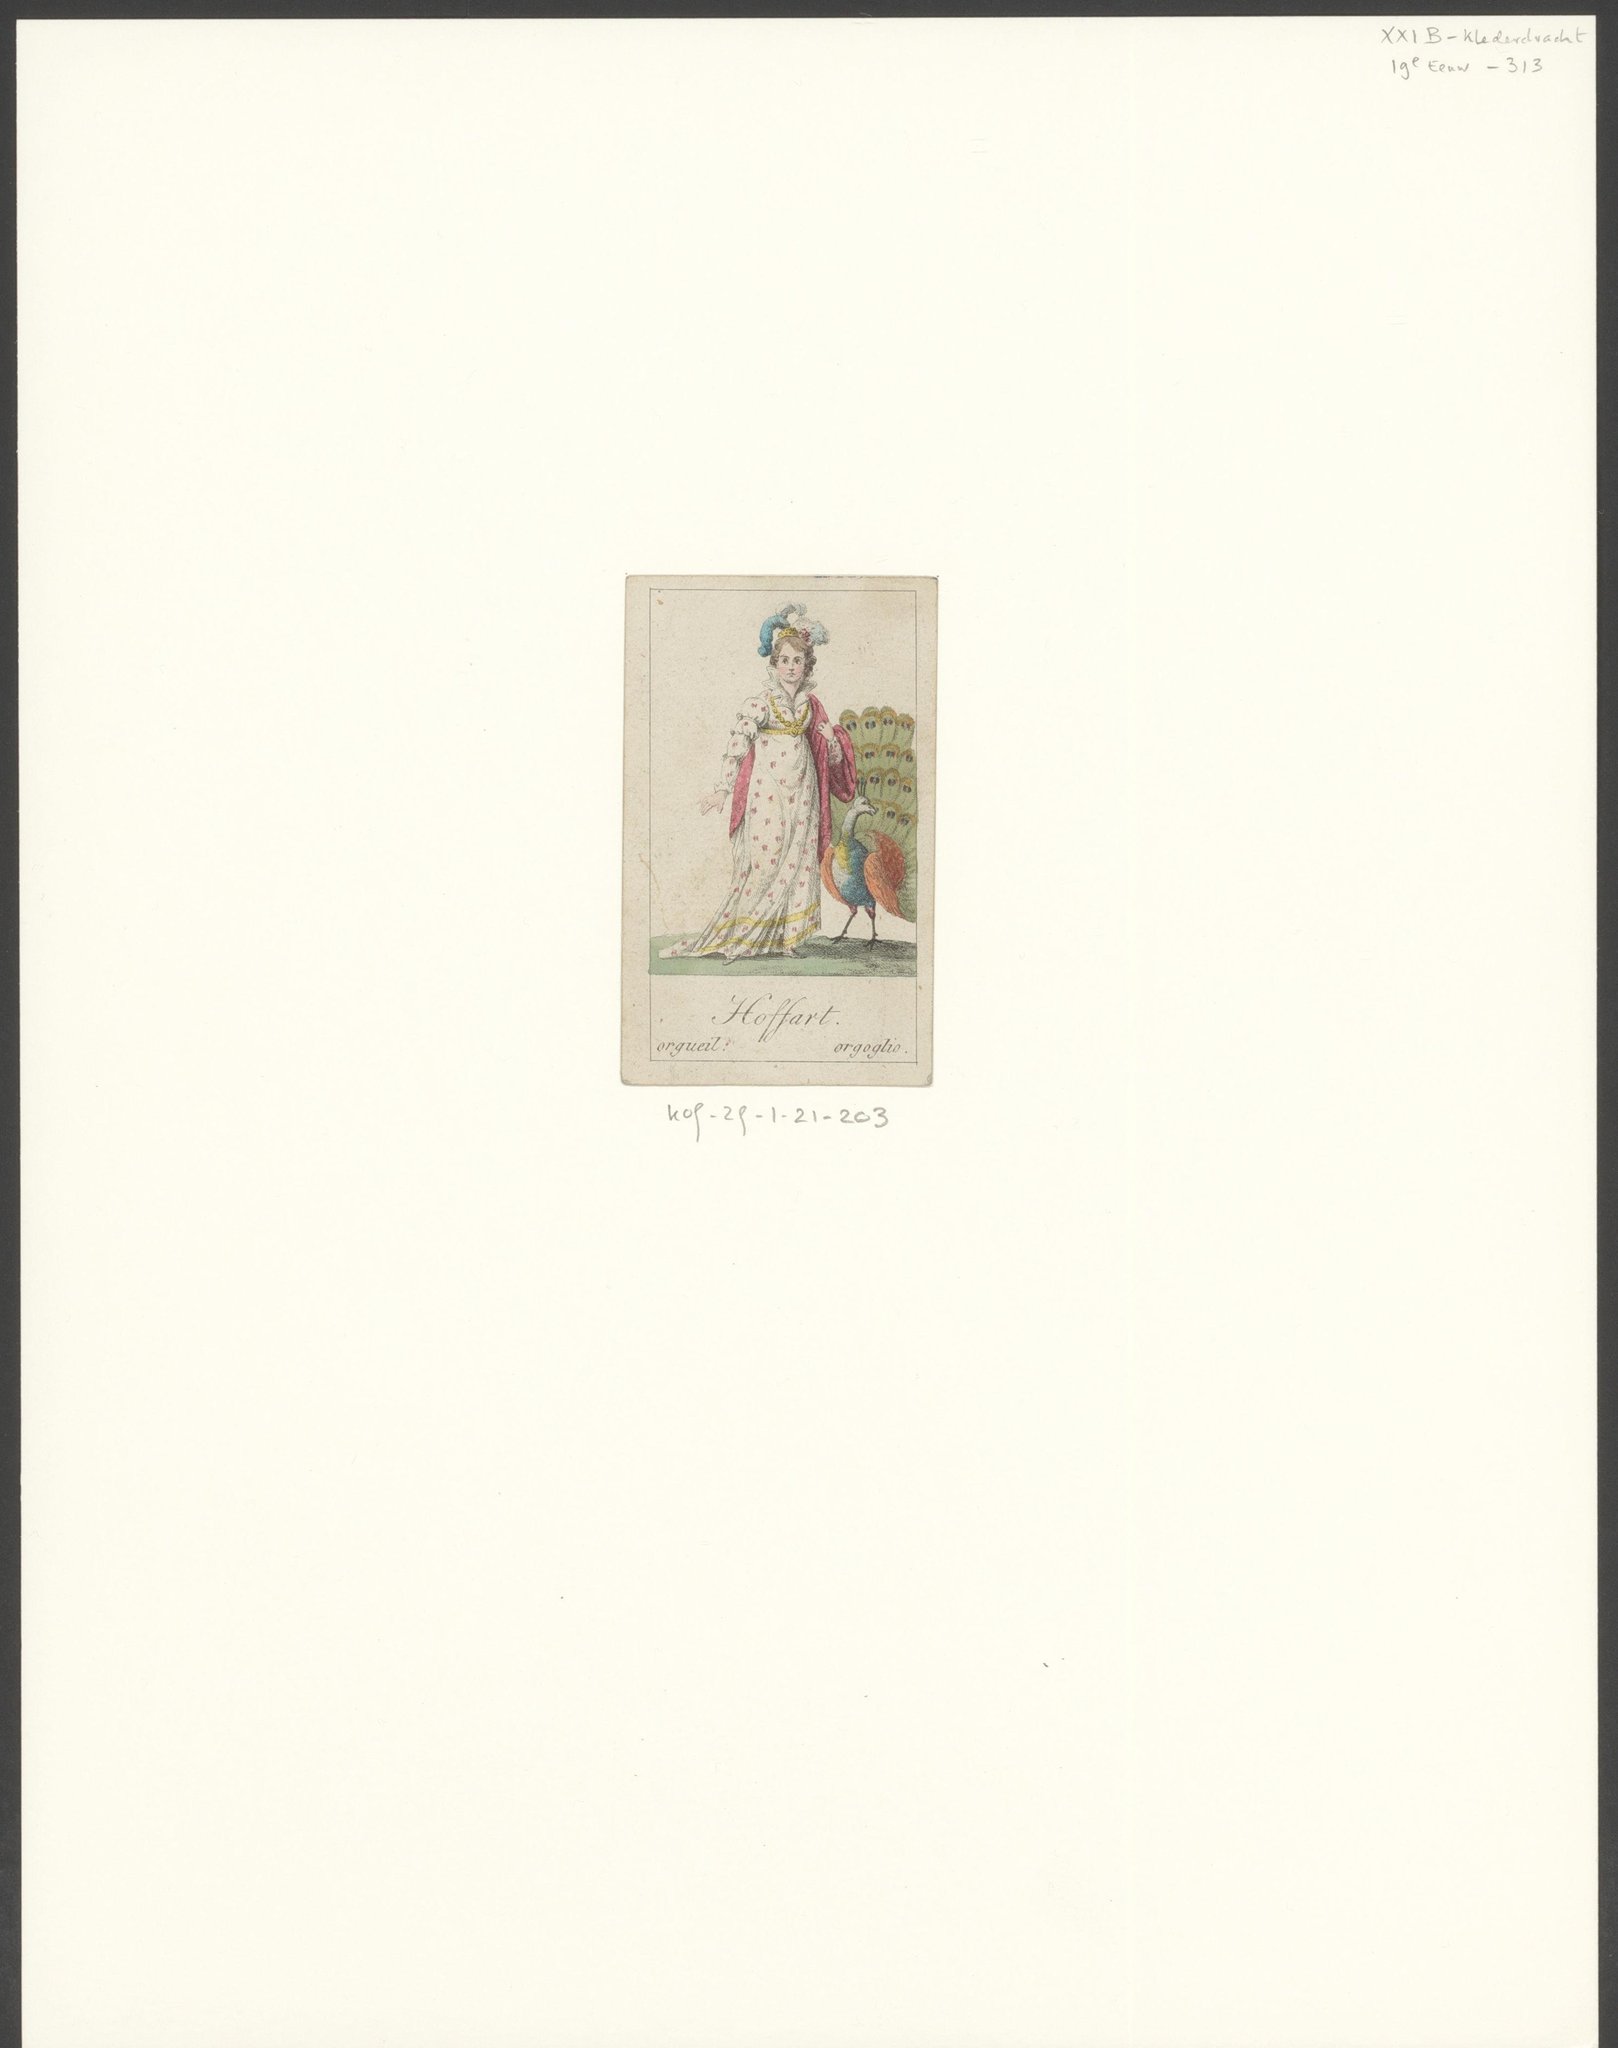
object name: print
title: Personificatie trots met pauw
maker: Anonymous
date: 1800-1849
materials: paper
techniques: engraving, etching, hand coloring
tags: pride; 'superbia' (ripa) ~ personification of one of the seven deadly sins, ornamental birds: peacock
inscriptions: stamp, collector's mark: Lugt 1641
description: Onderwerpsrubrieken binnen de Atlas Zeden en Gewoonten: Zeden en Gewoonten in Engeren Zin, De Kleeding, Kleederdrachten (tijdvakken), Het begin der 19de eeuw. Mannen en vrouwen.